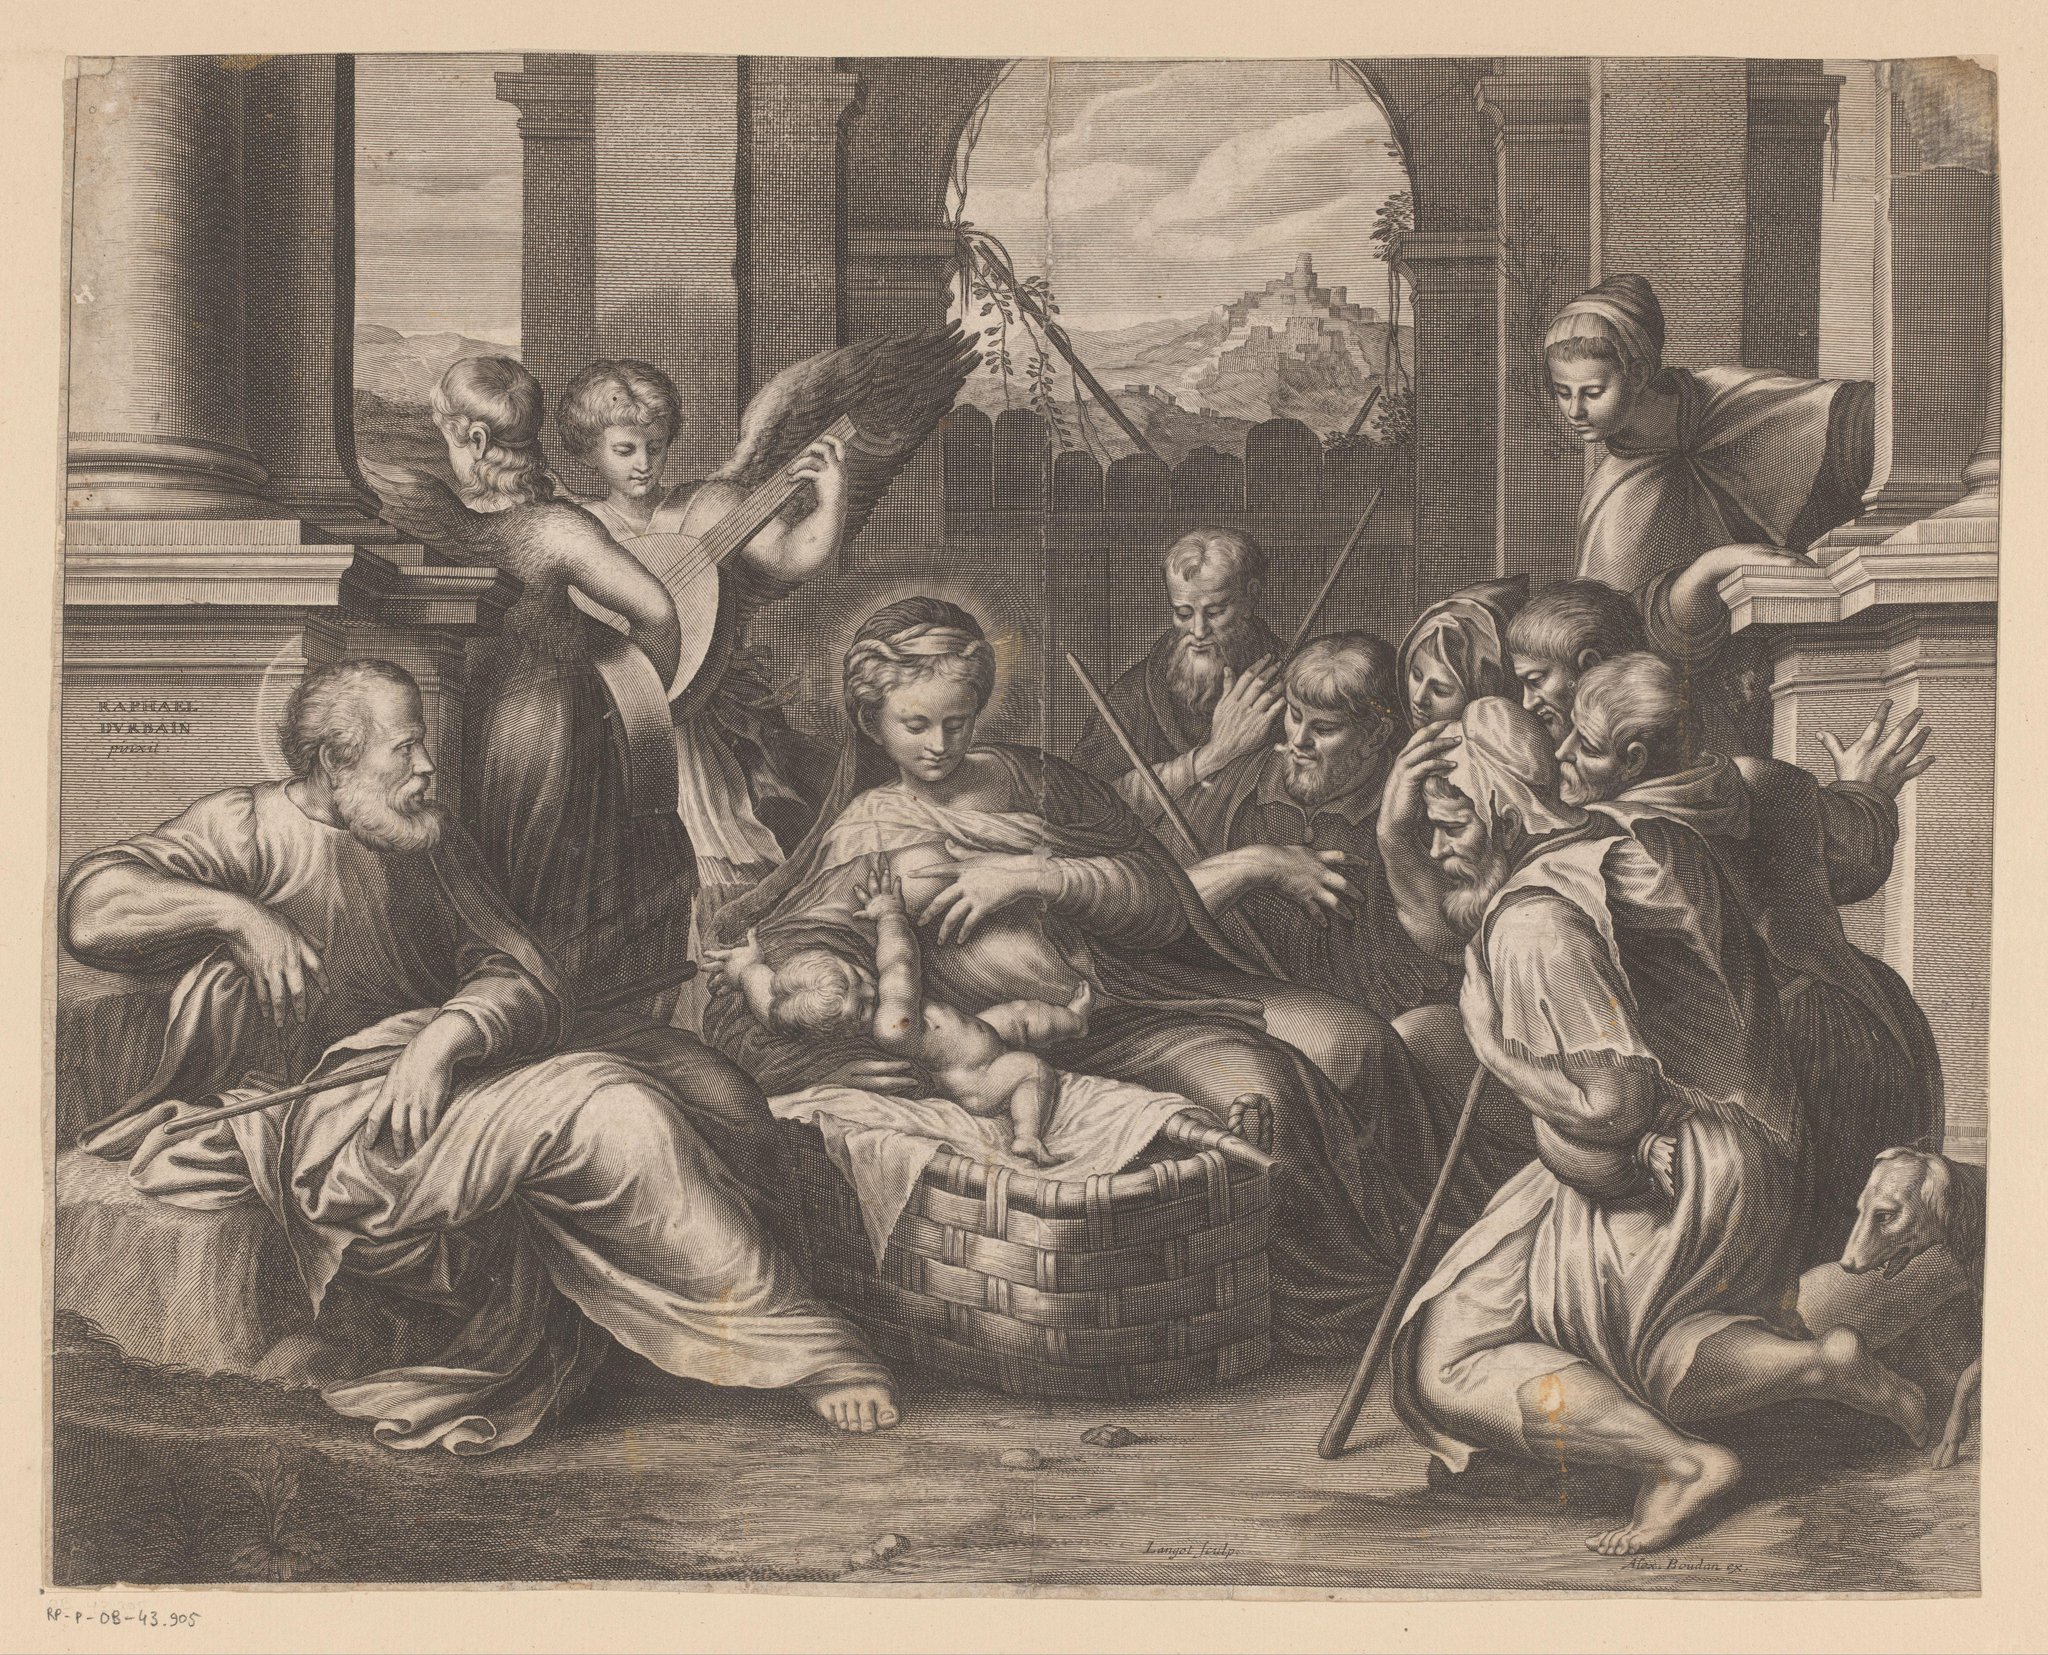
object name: print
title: Aanbidding door de herders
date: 1610-1671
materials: paper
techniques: engraving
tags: adoration of the christ-child by the shepherds; mary and joseph present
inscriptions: collector's mark: Lugt 240